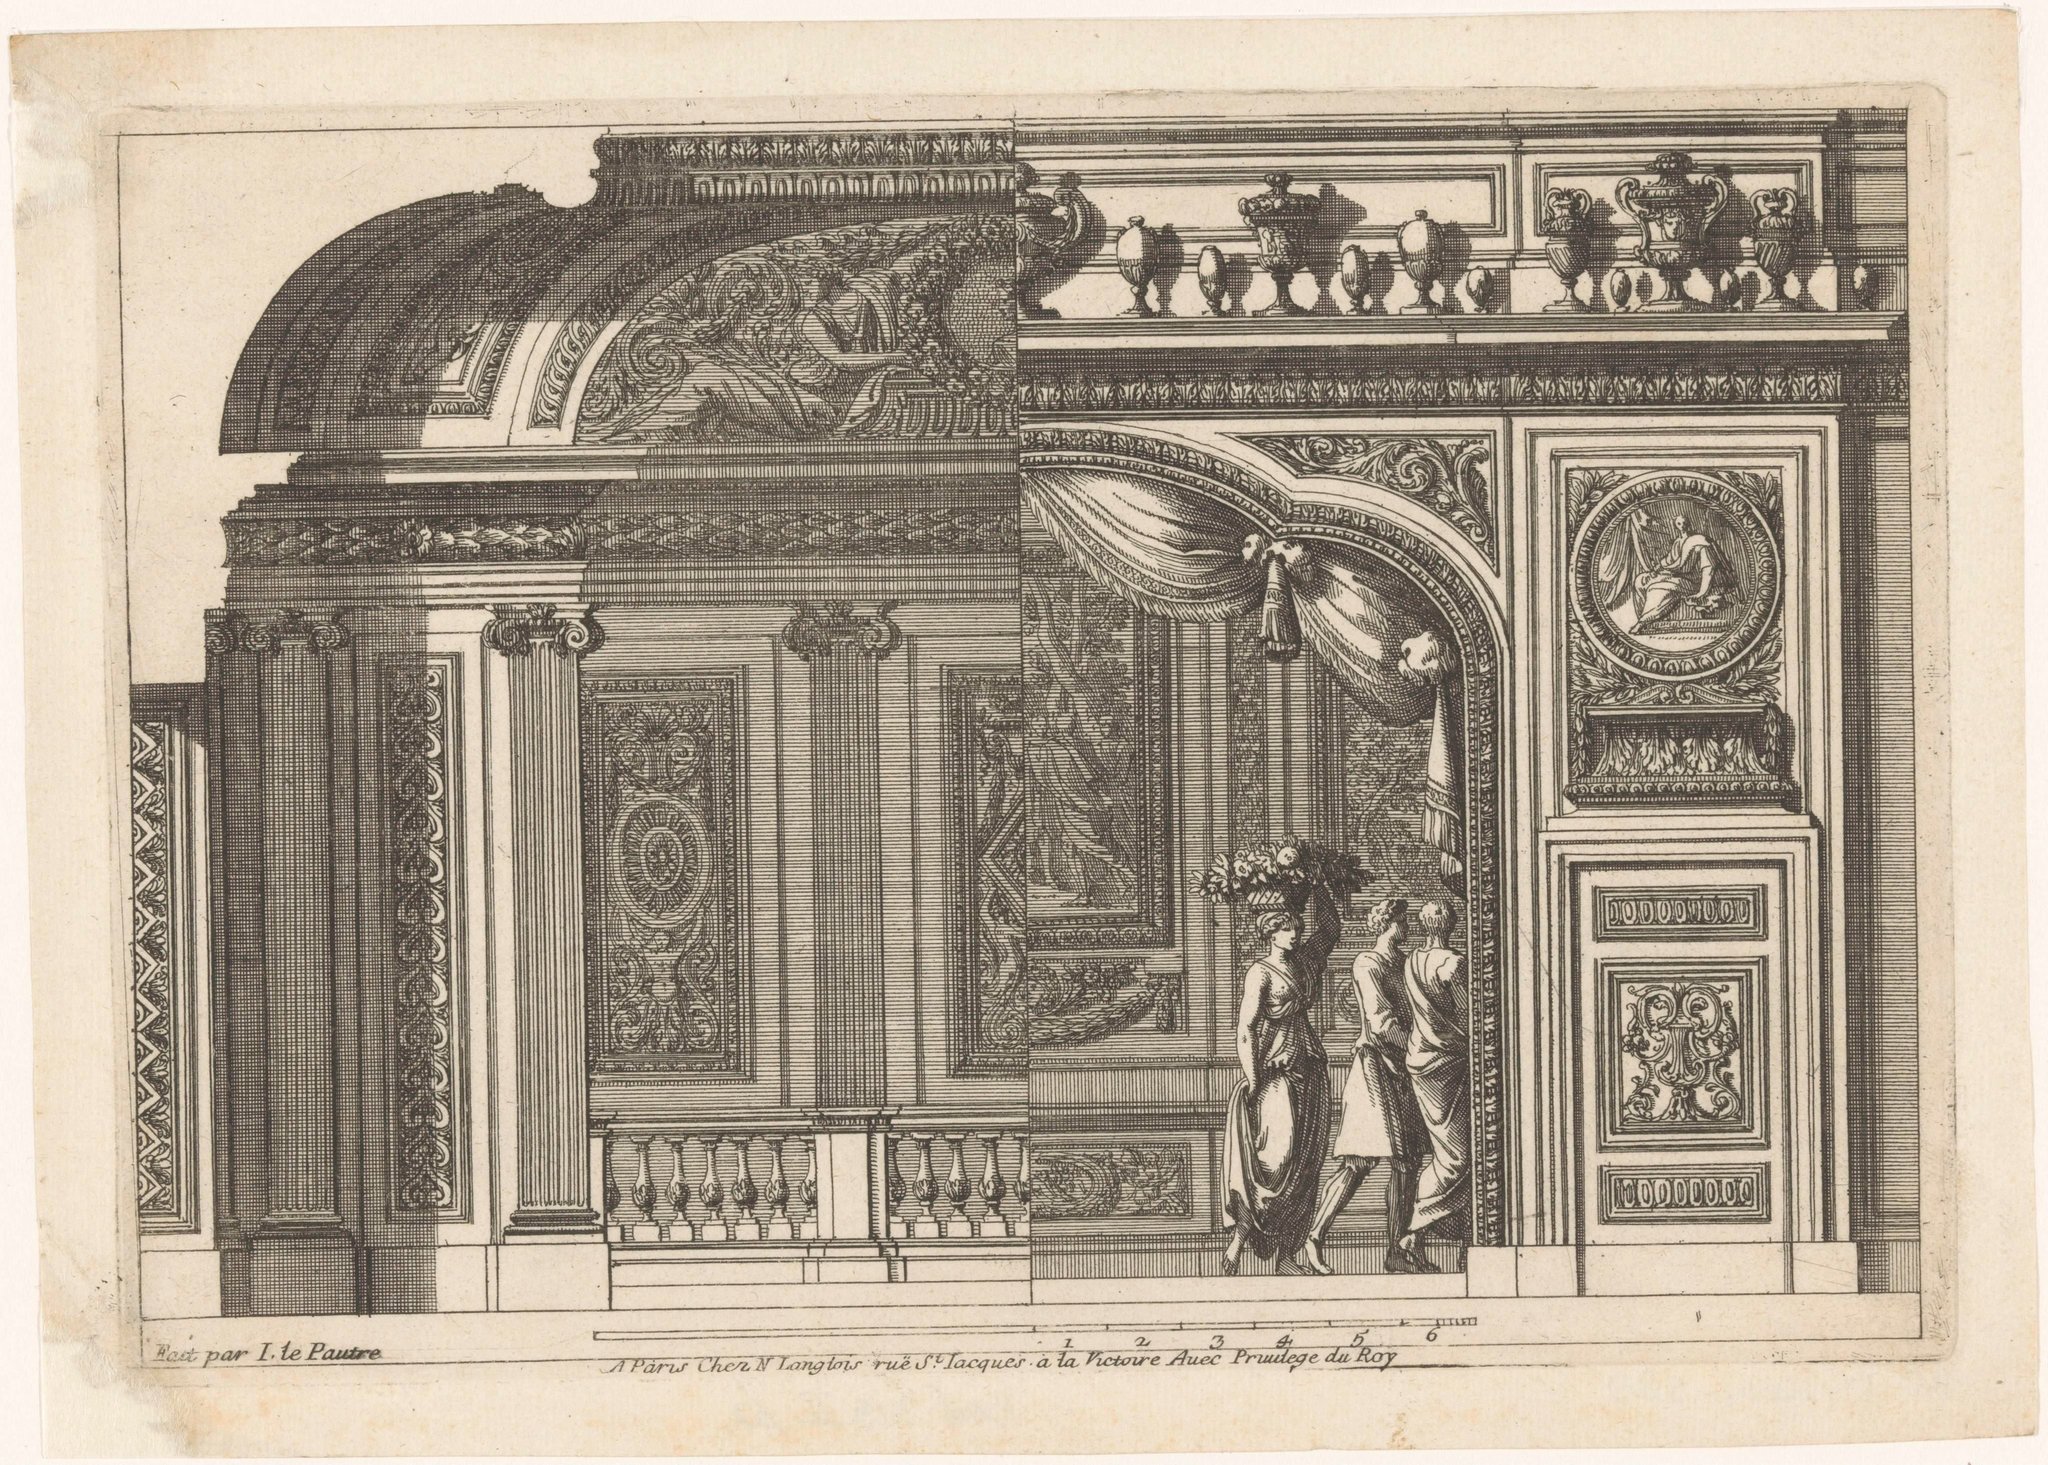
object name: print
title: Alcoves à la Francoise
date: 1678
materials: paper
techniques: etching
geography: paris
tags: interior of the house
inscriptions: collector's mark: Lugt 2228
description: Alkoof met aan de linkerkant Ionische pilasters tegen de muur, afgesloten door een balustrade. De rechterkant is een variant met een deur met dessus-de-porte met figuur in medaillon.